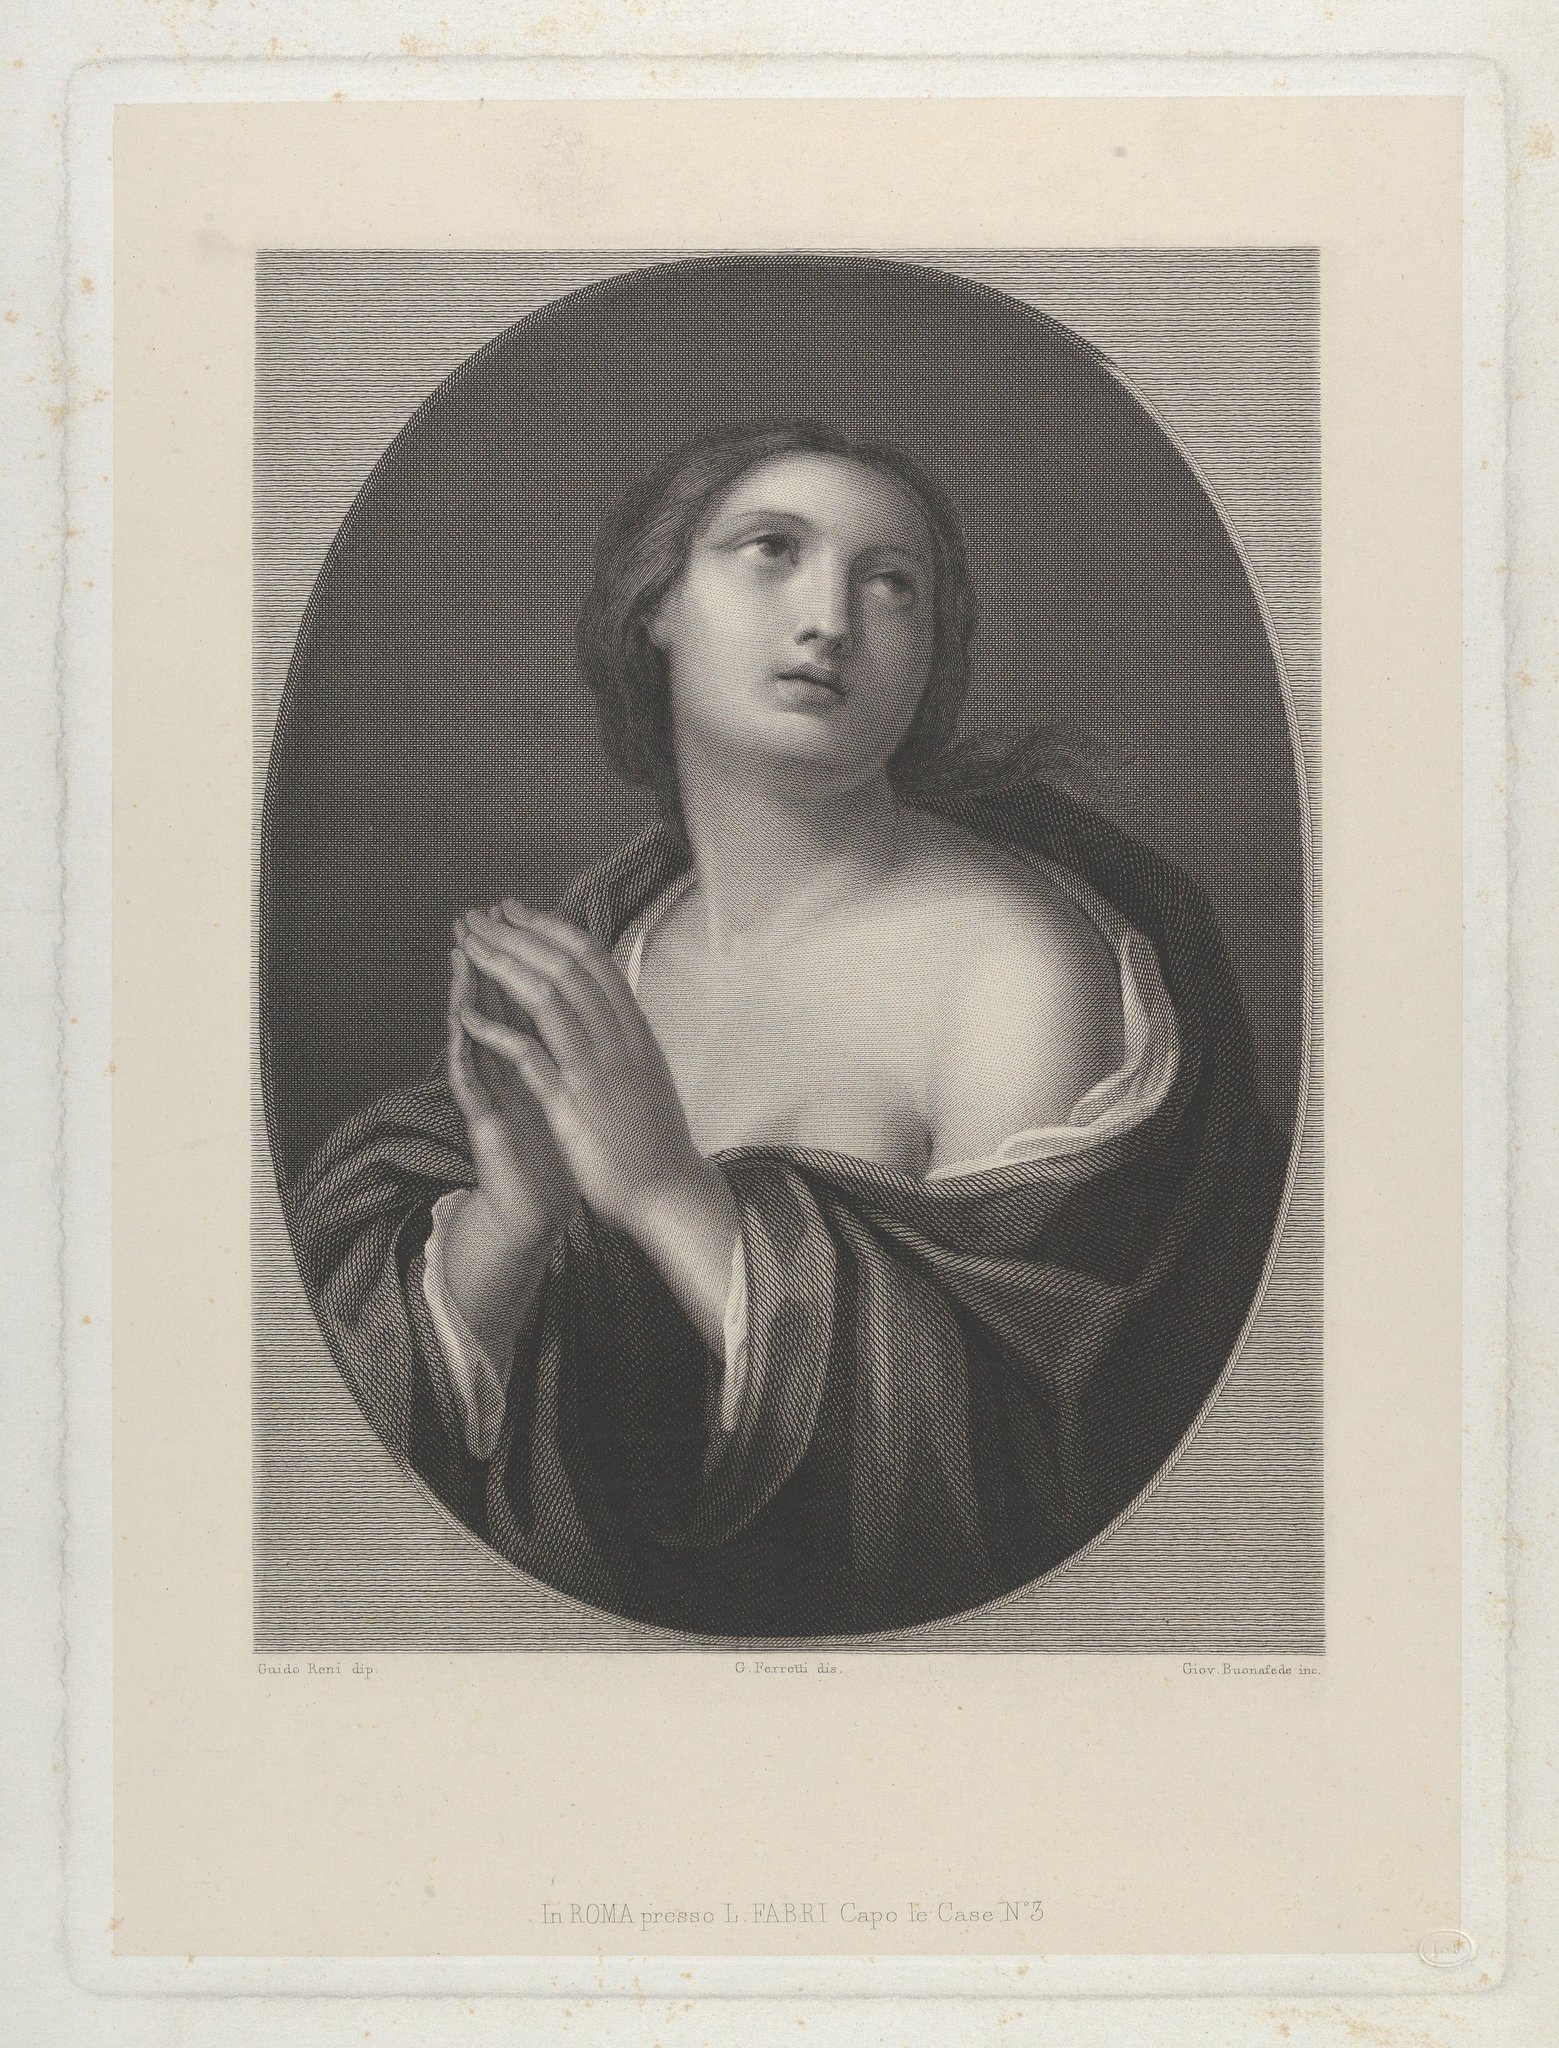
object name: print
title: Female personification of Hope looking up with hands held together and left shoulder exposed, in an oval frame, after Reni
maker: giovanni buonafede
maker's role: artist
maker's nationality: italian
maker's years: 1816-1916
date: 1835-1881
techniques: engraving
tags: portraits,women